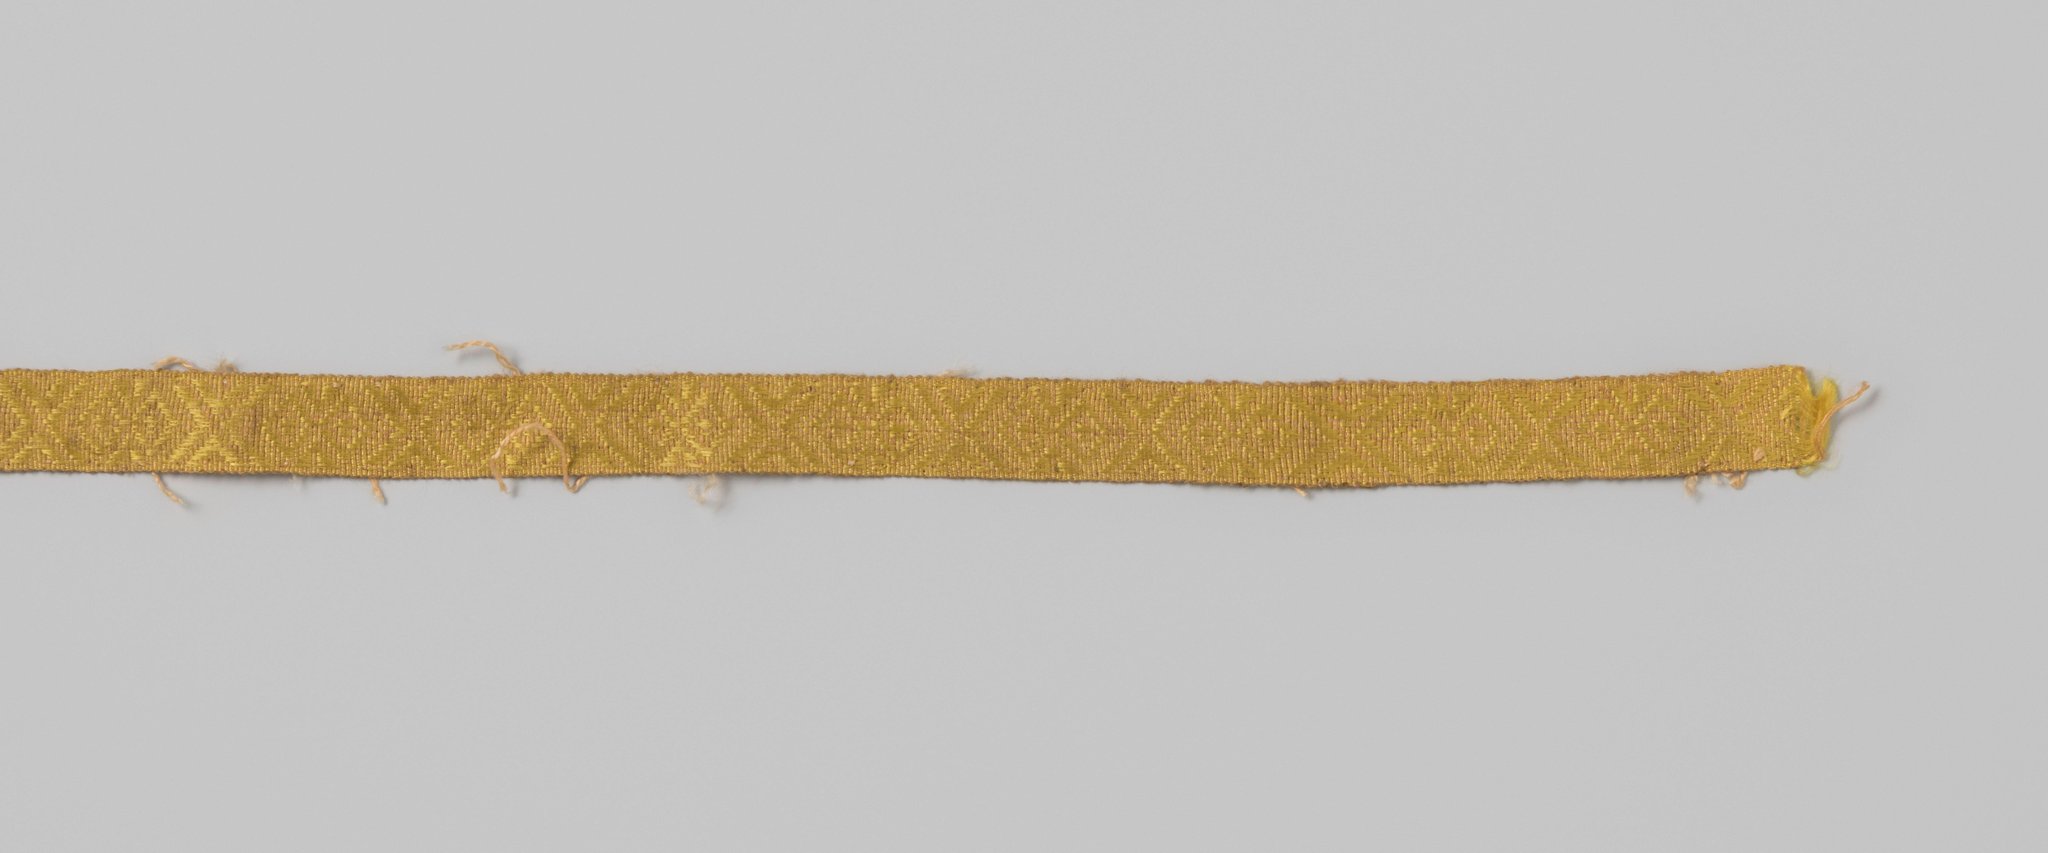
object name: braid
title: Passement van linnen en gele zijde in ruitpatroon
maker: Anonymous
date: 1700-1899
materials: linen, silk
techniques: weave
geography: europe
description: Passement van linnen en gele zijde in een patroon van ruiten in ruiten. BK-NM-12186-19, BK-NM-12186-20-A en BK-NM-12186-20-B hebben eenzelfde patroon.